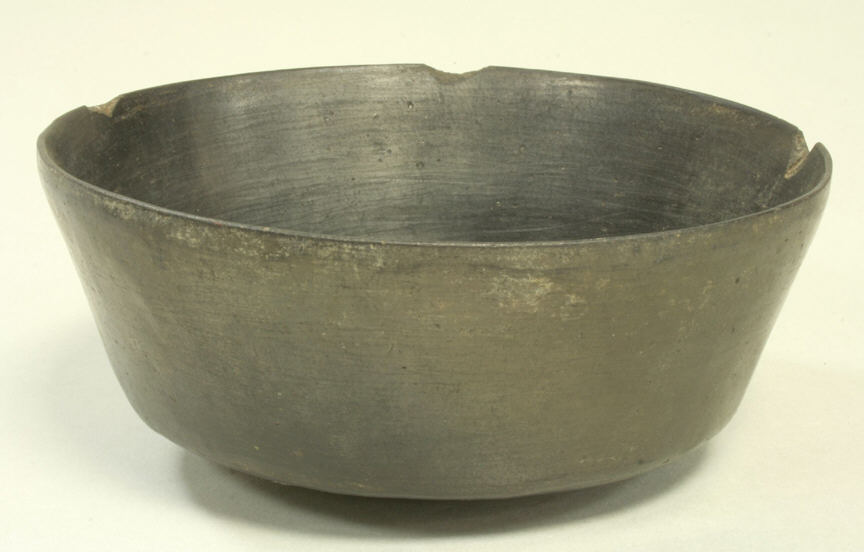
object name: bowl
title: Blackware Bowl with Fish and Scroll Motif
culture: nasca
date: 200-101 BCE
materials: ceramic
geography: peru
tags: birds